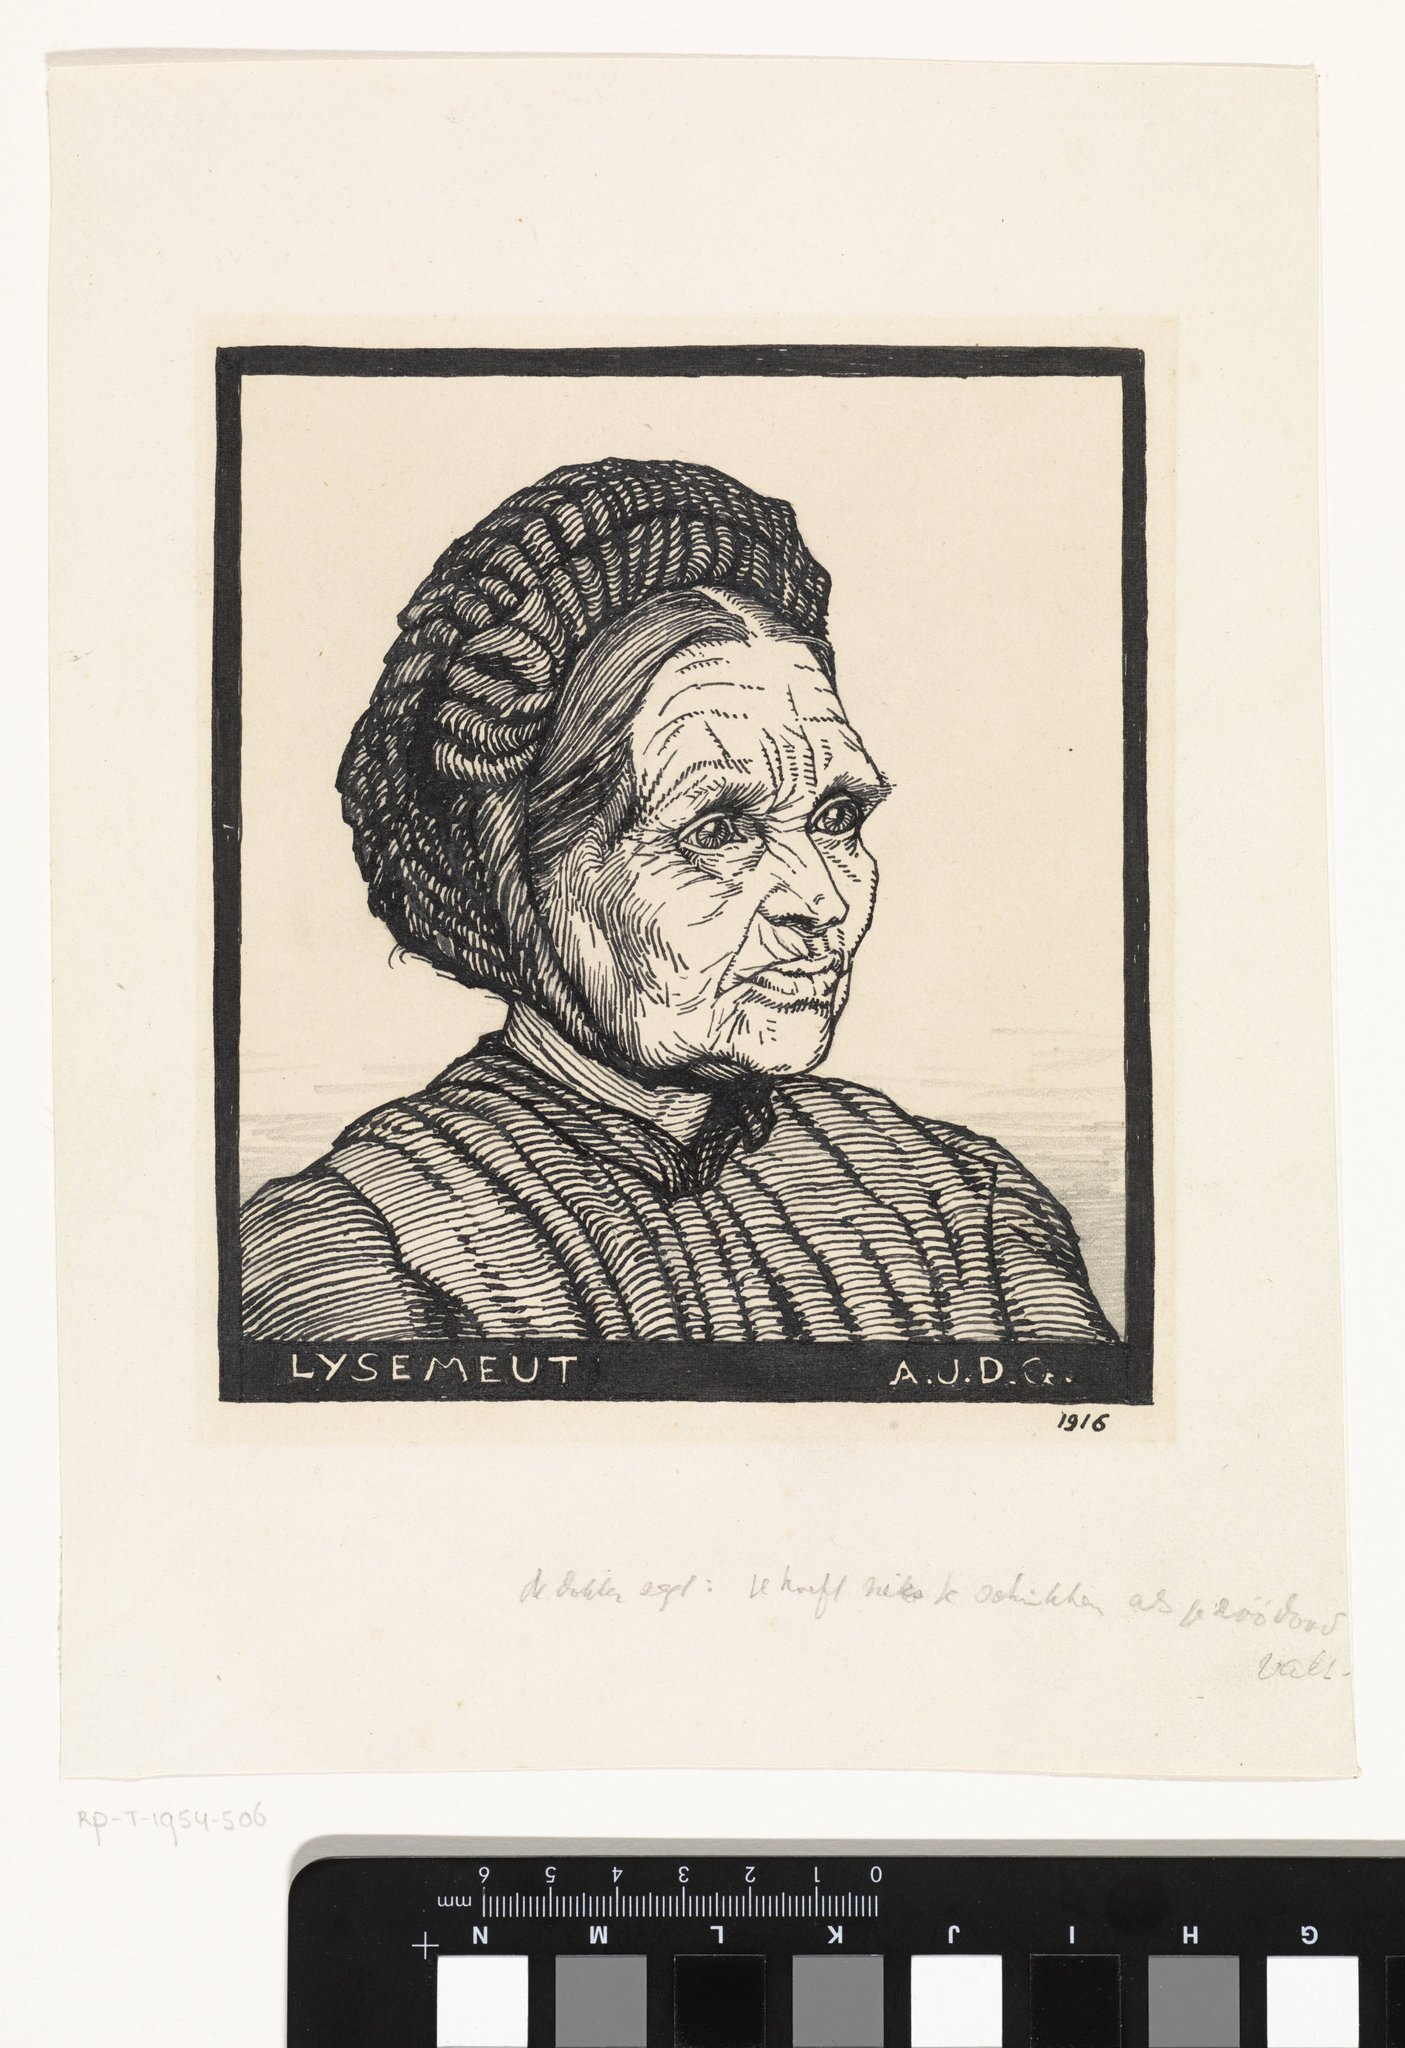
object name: drawing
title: Portret van Larense boerenvrouw genaamd Lysemeut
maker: julie de graag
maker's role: draughtsman, print maker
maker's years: 1877-1924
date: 1916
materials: ink, paper, pencil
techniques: brush, pen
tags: historical persons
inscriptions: date: ‘1916’